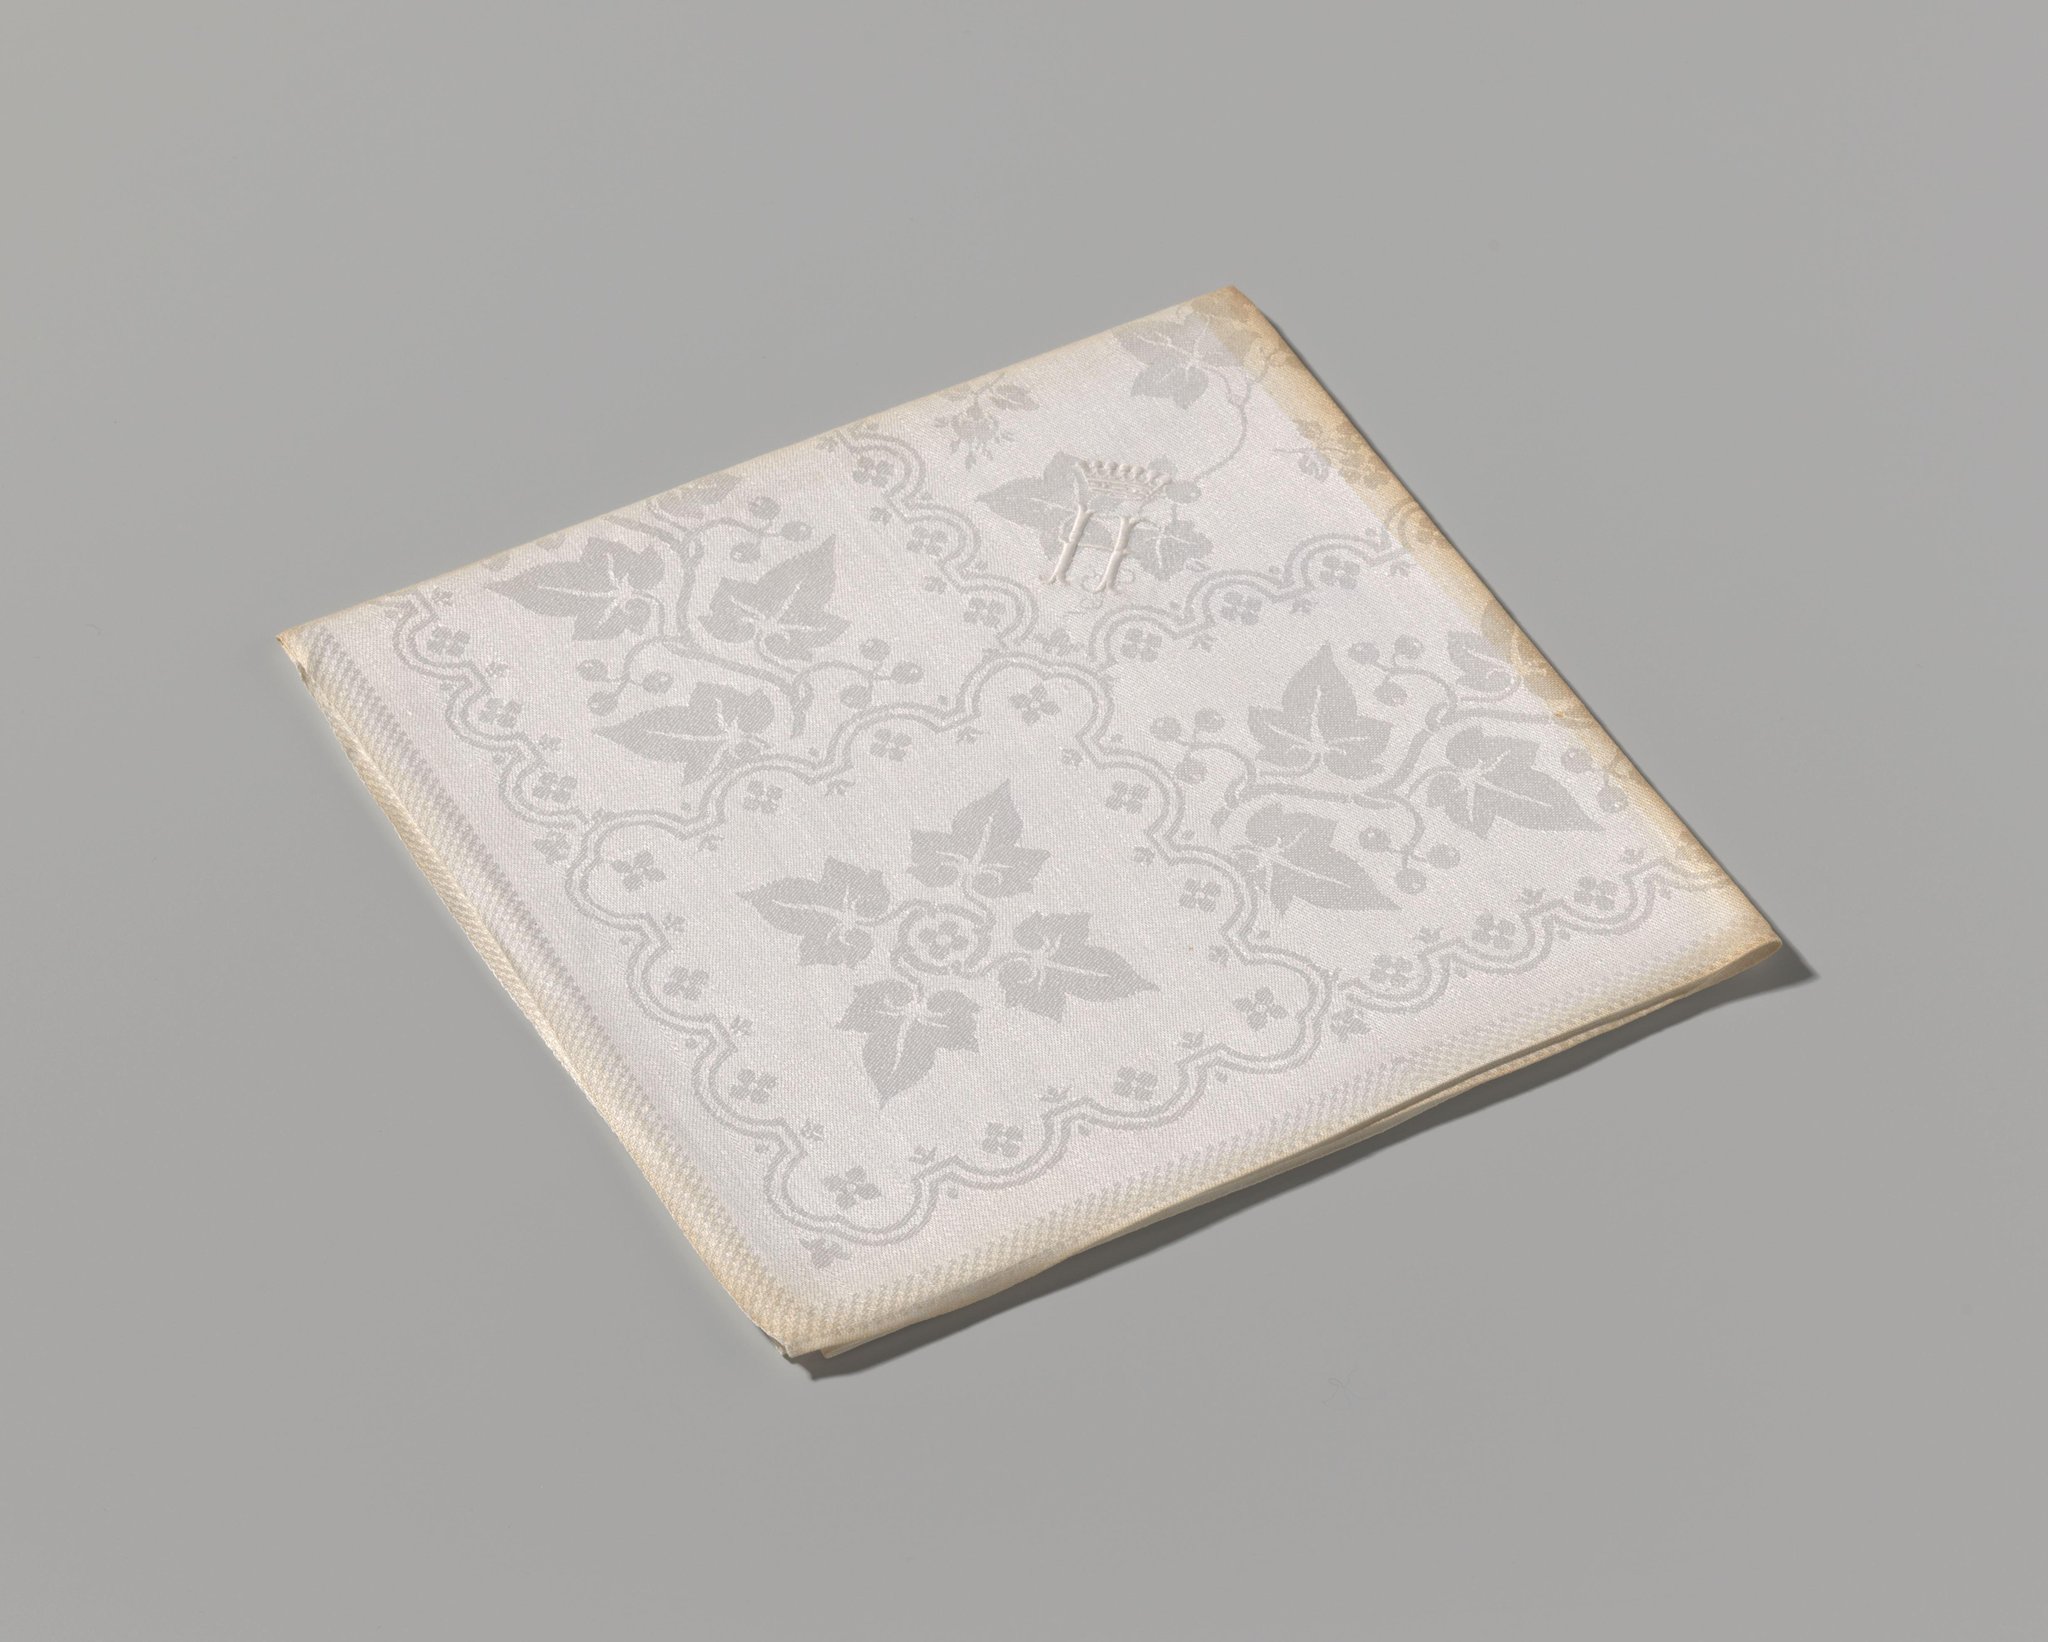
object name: napkin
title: Servet van wit linnendamast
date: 1890-1914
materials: linen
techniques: damask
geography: bielefeld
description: Wit linnen damasten servet met klimop- patroon, merk kroon H.